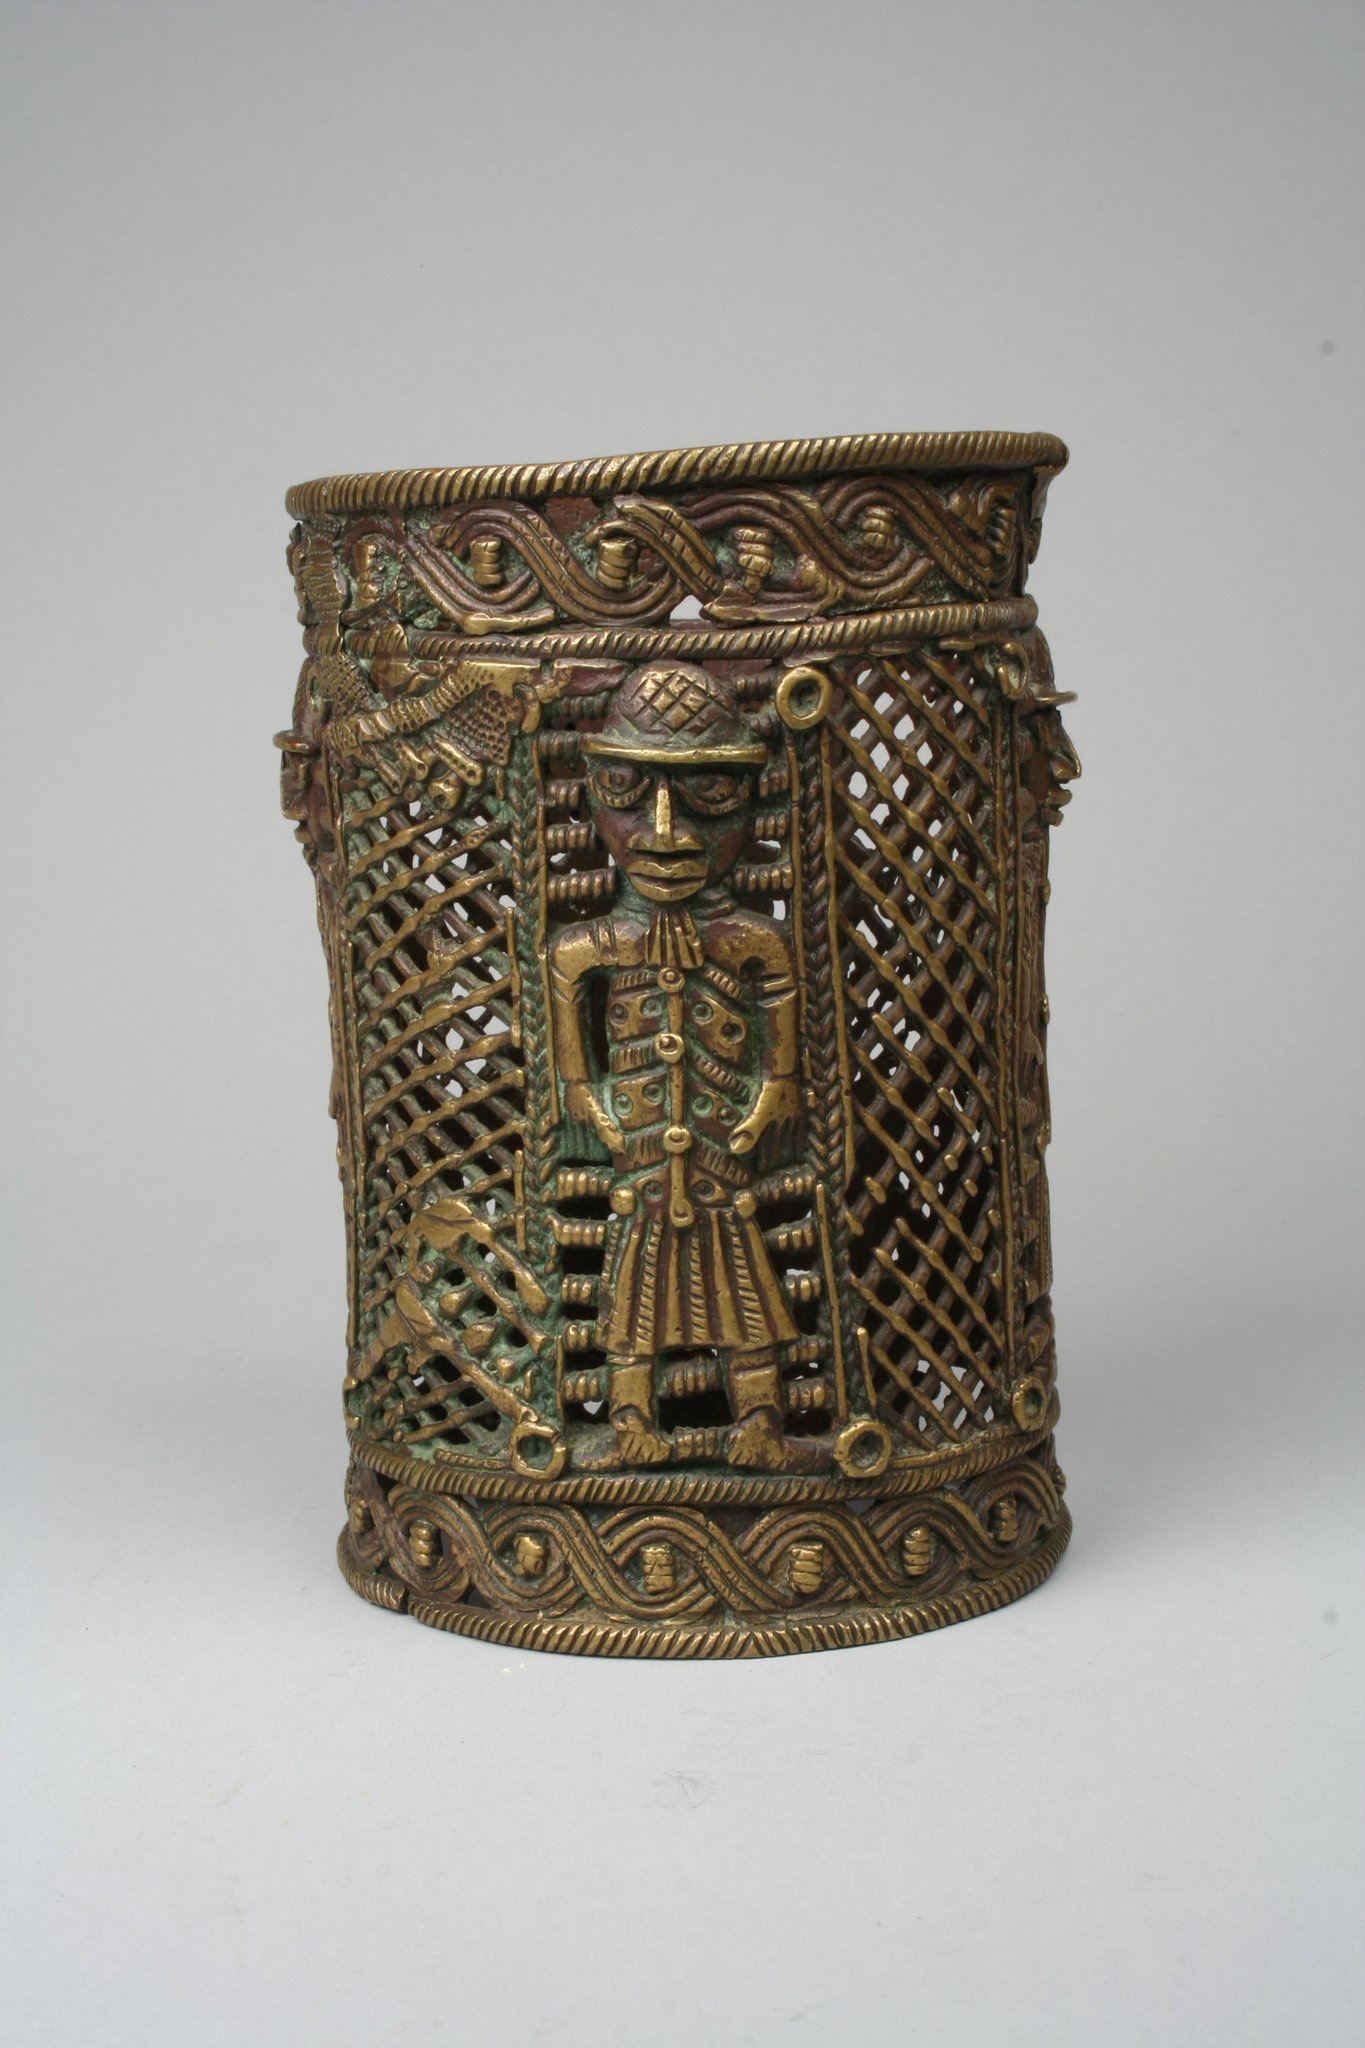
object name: bracelet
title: Bracelet: Four Figures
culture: edo period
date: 1801-1900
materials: brass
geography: nigeria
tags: human figures